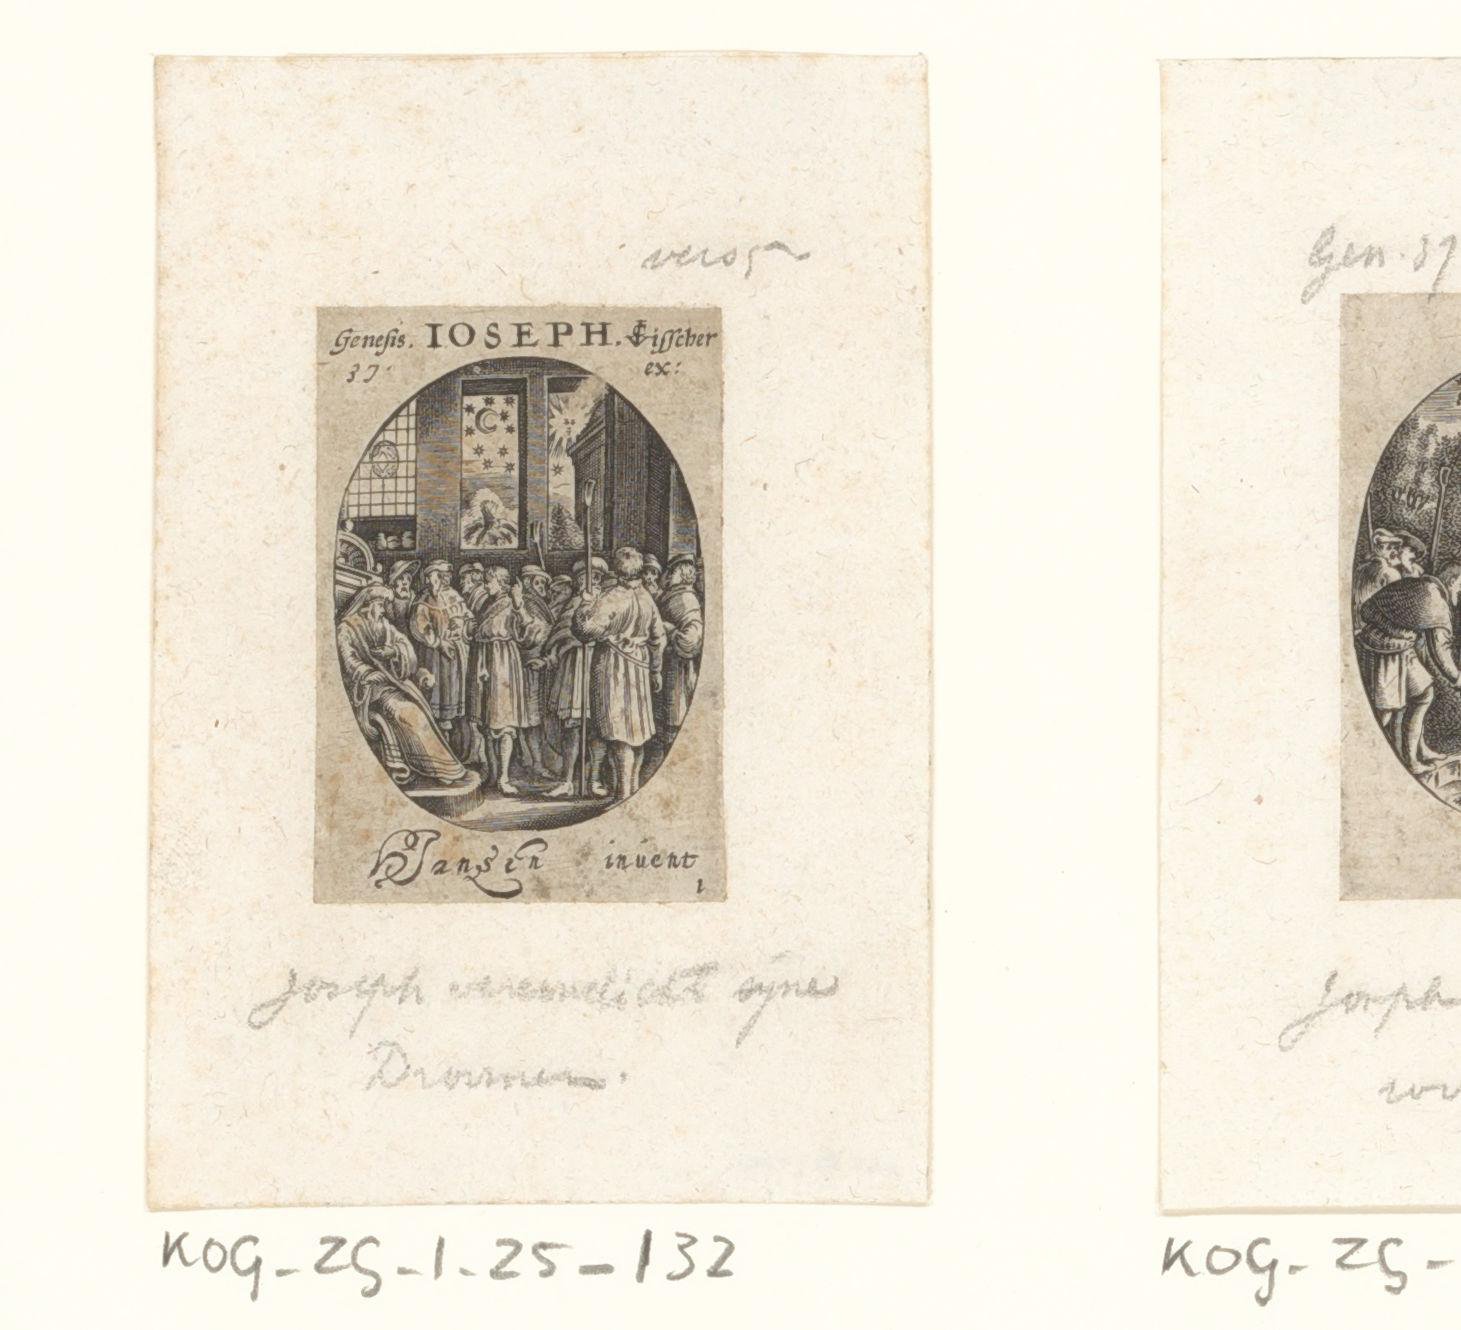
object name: print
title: Joseph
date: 1605-1652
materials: paper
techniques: engraving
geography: amsterdam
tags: joseph's dreams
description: Rechtsonder genummerd: 1. Onderwerpsrubrieken binnen de Atlas Zeden en Gewoonten: Zeden en Gewoonten in Engeren Zin, De Woning, Huisraad, Zilverwerk.